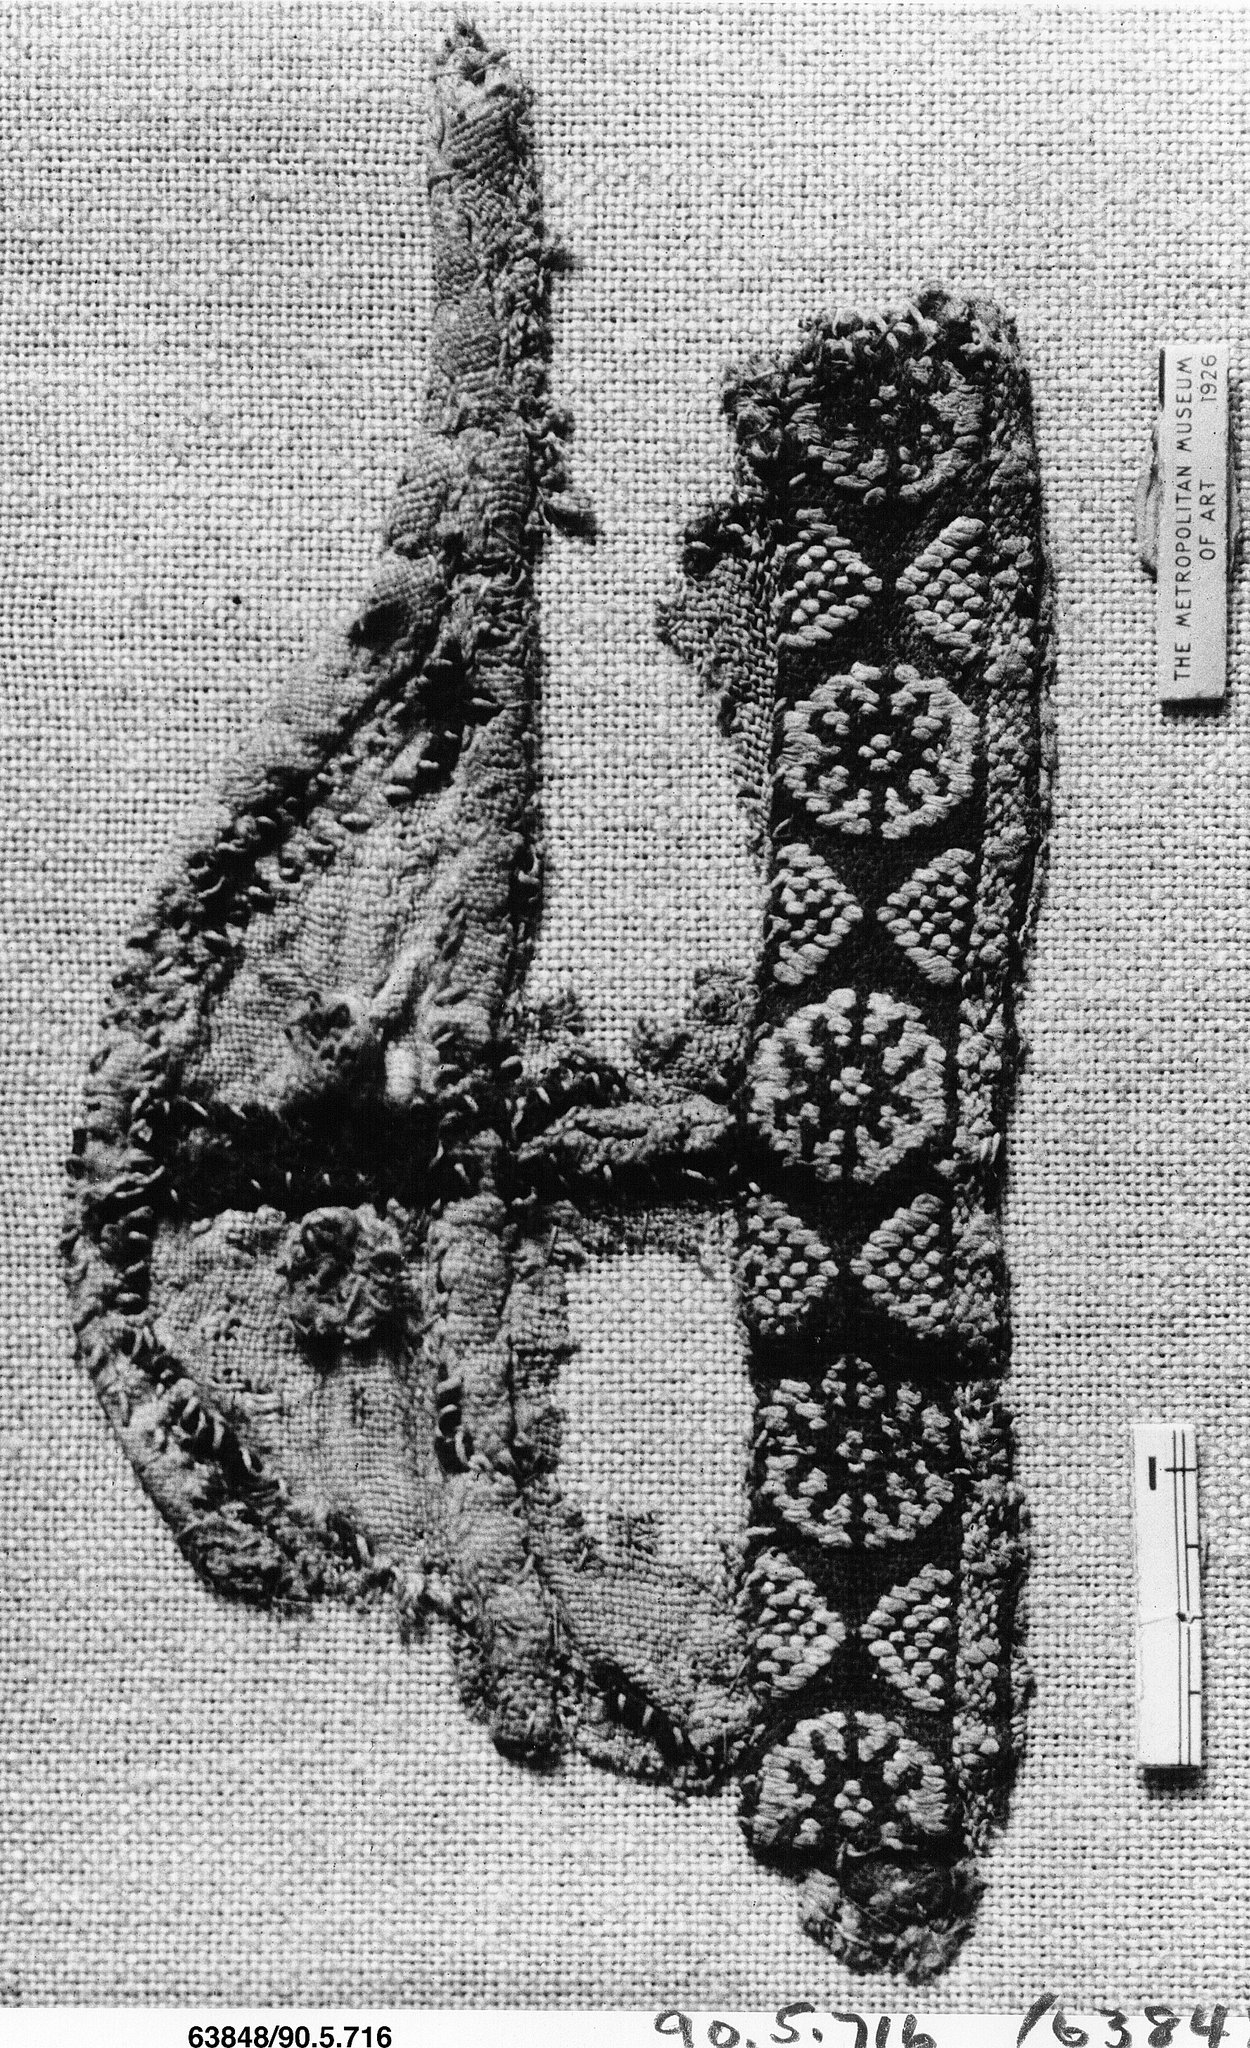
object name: textile fragment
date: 401-600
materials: linen, wool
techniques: weave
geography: egypt